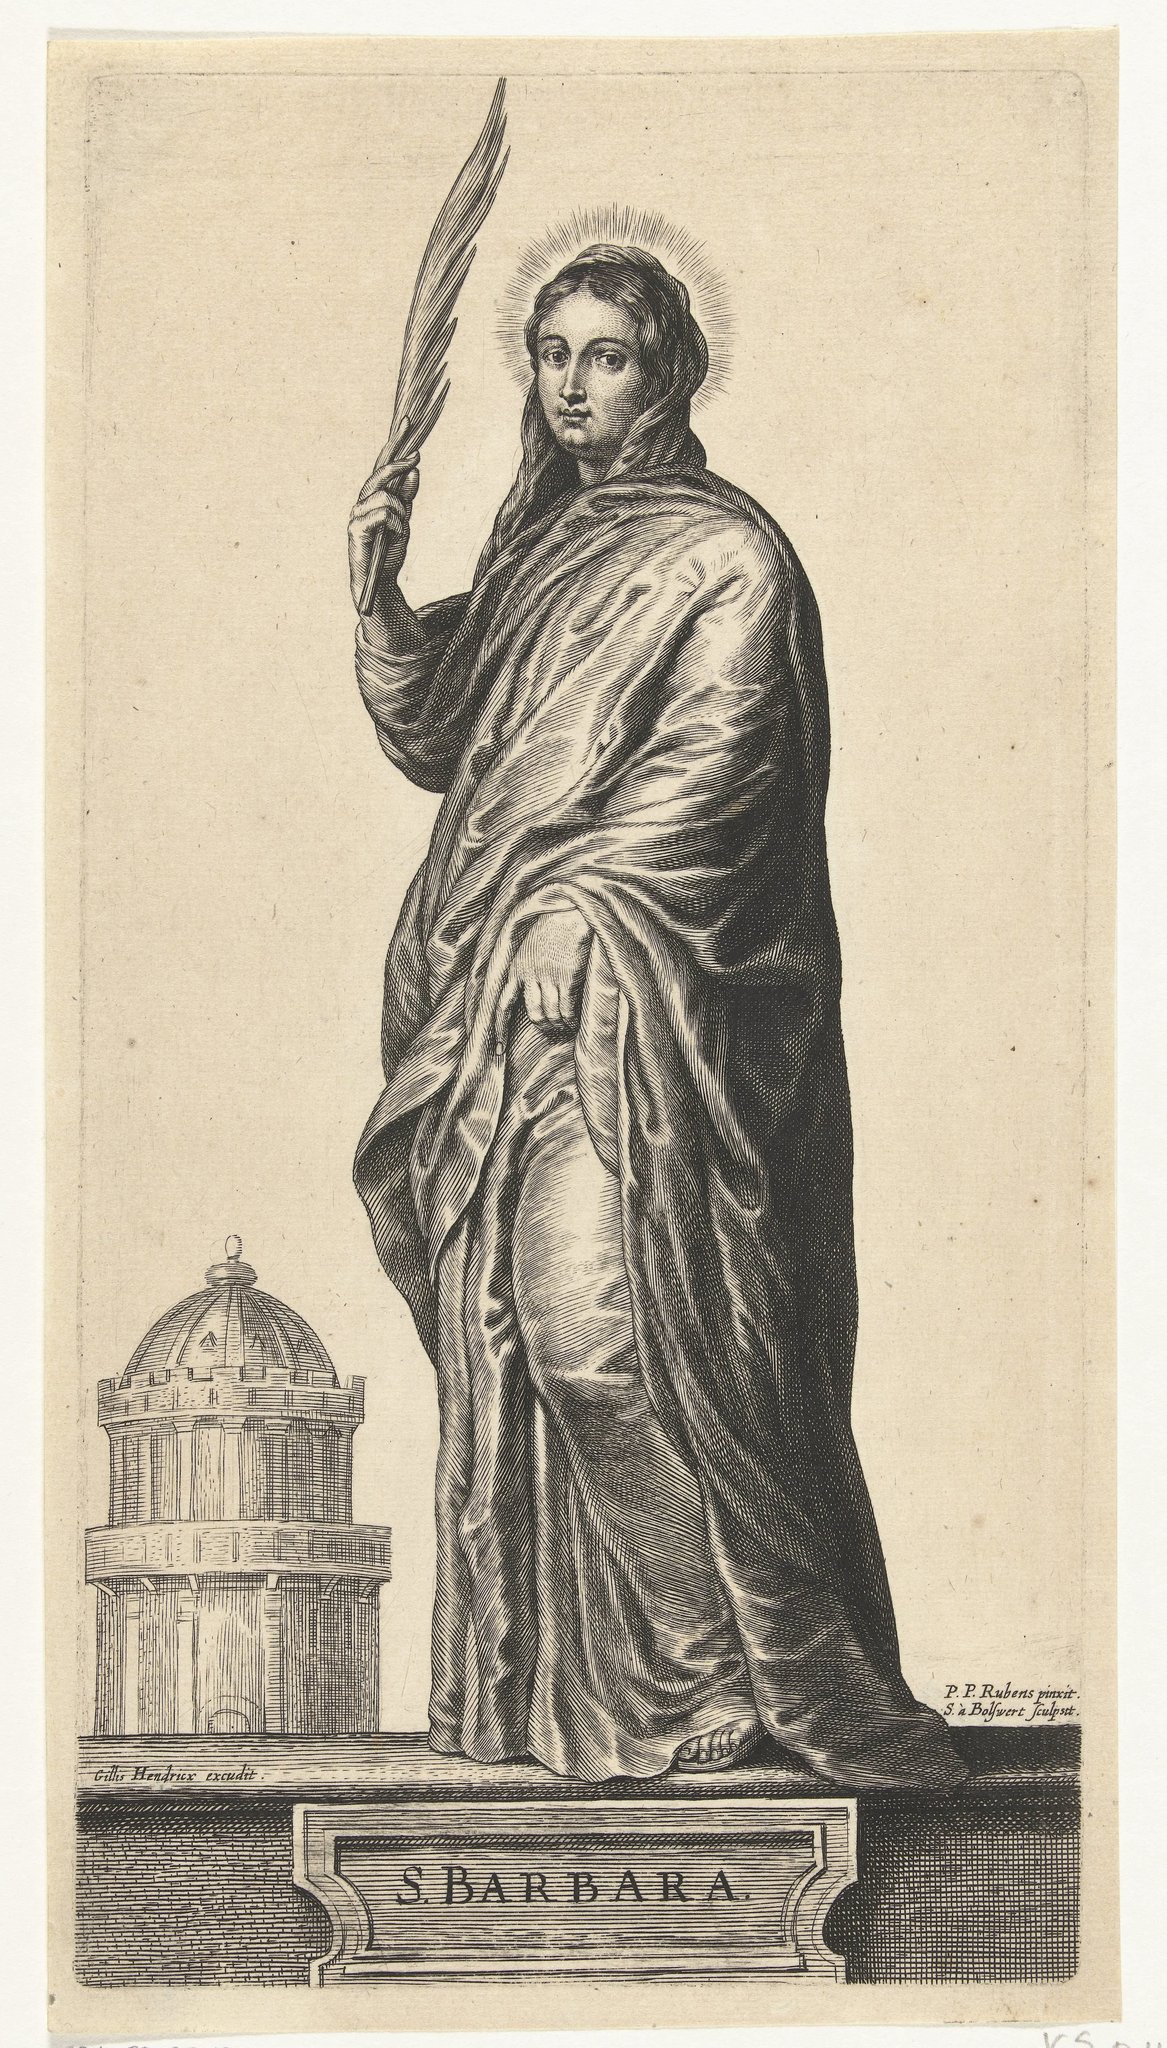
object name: print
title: Heilige Barbara met toren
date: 1596-1659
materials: paper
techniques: engraving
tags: the virgin martyr barbara; possible attributes: book, cannon(ball), crown, cross, chalice with wafer, dioscuros (her father), peacock feather, sword, torches, mason's tools, tower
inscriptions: collector's mark: Lugt 240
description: Prent naar schilderij van Peter Paul Rubens.